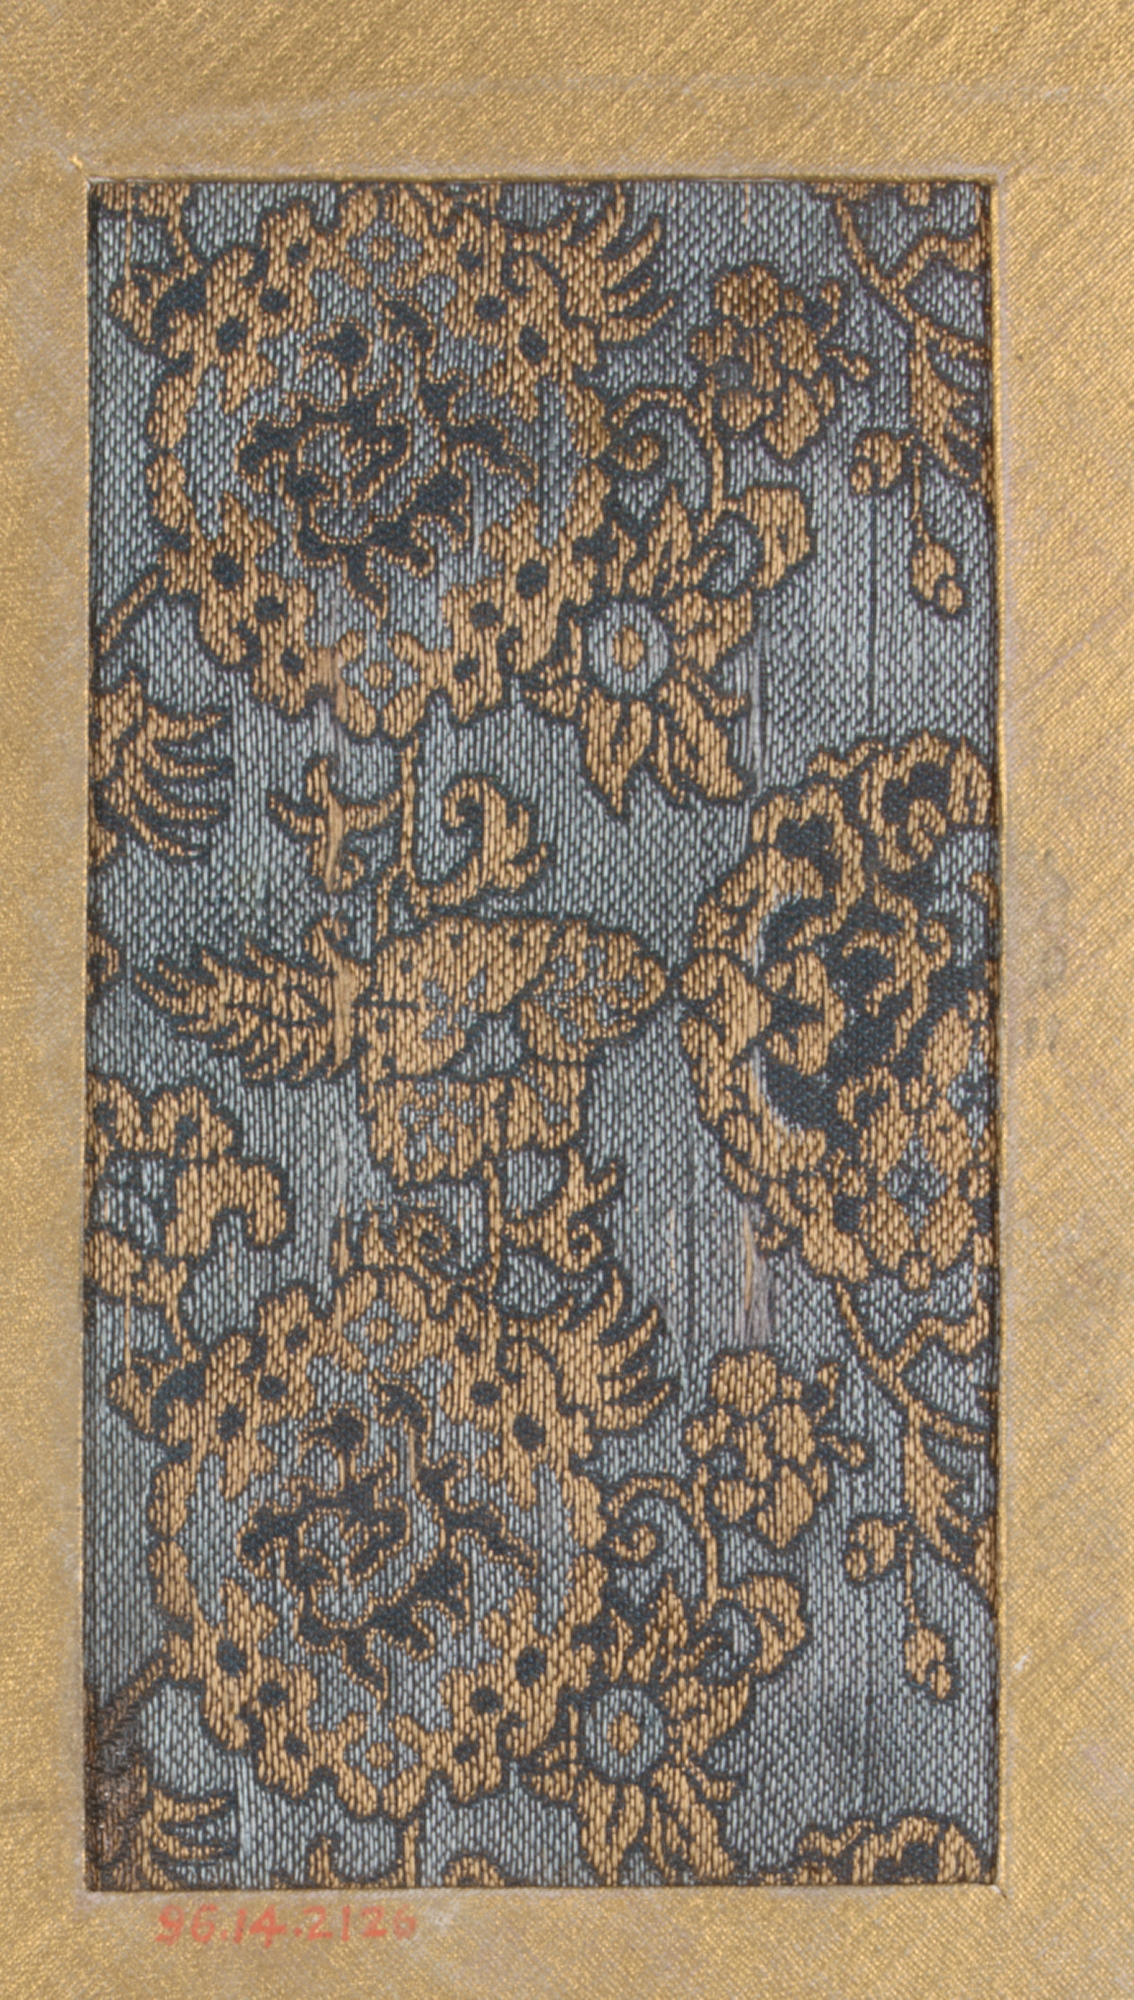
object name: piece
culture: japanese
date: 1701-1900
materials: silk